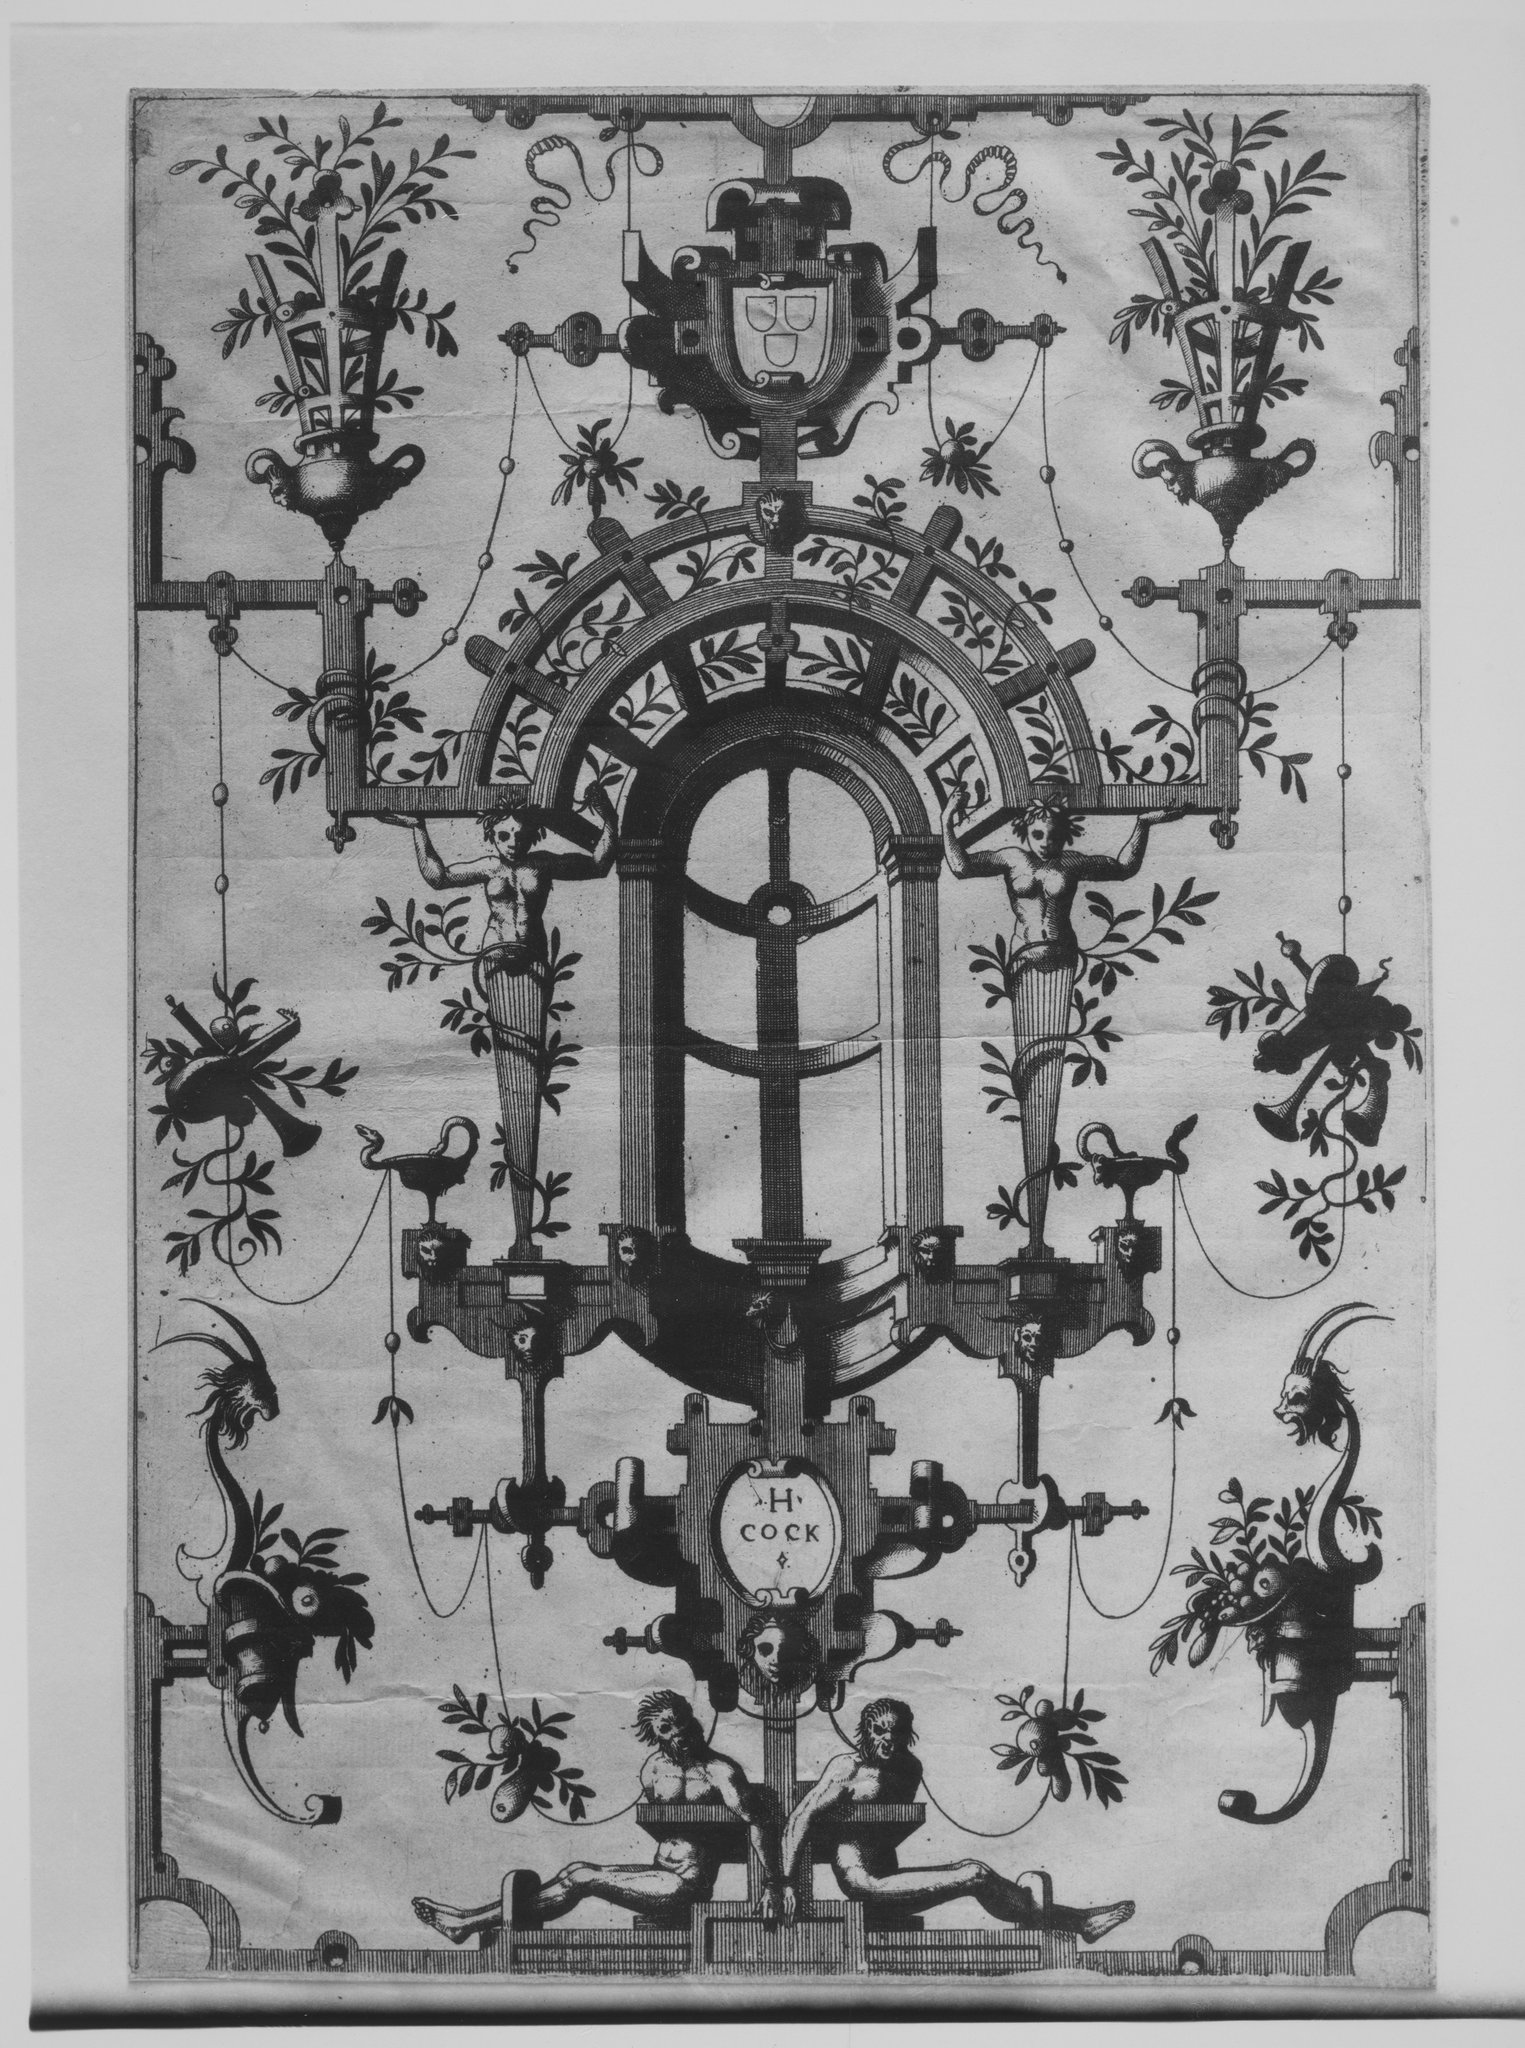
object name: book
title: Various Plates of Grotesques from Three Series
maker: cornelis floris ii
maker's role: artist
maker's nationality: netherlandish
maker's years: 1514-1575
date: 1554-1557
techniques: etching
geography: belgium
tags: grotesques,ornament